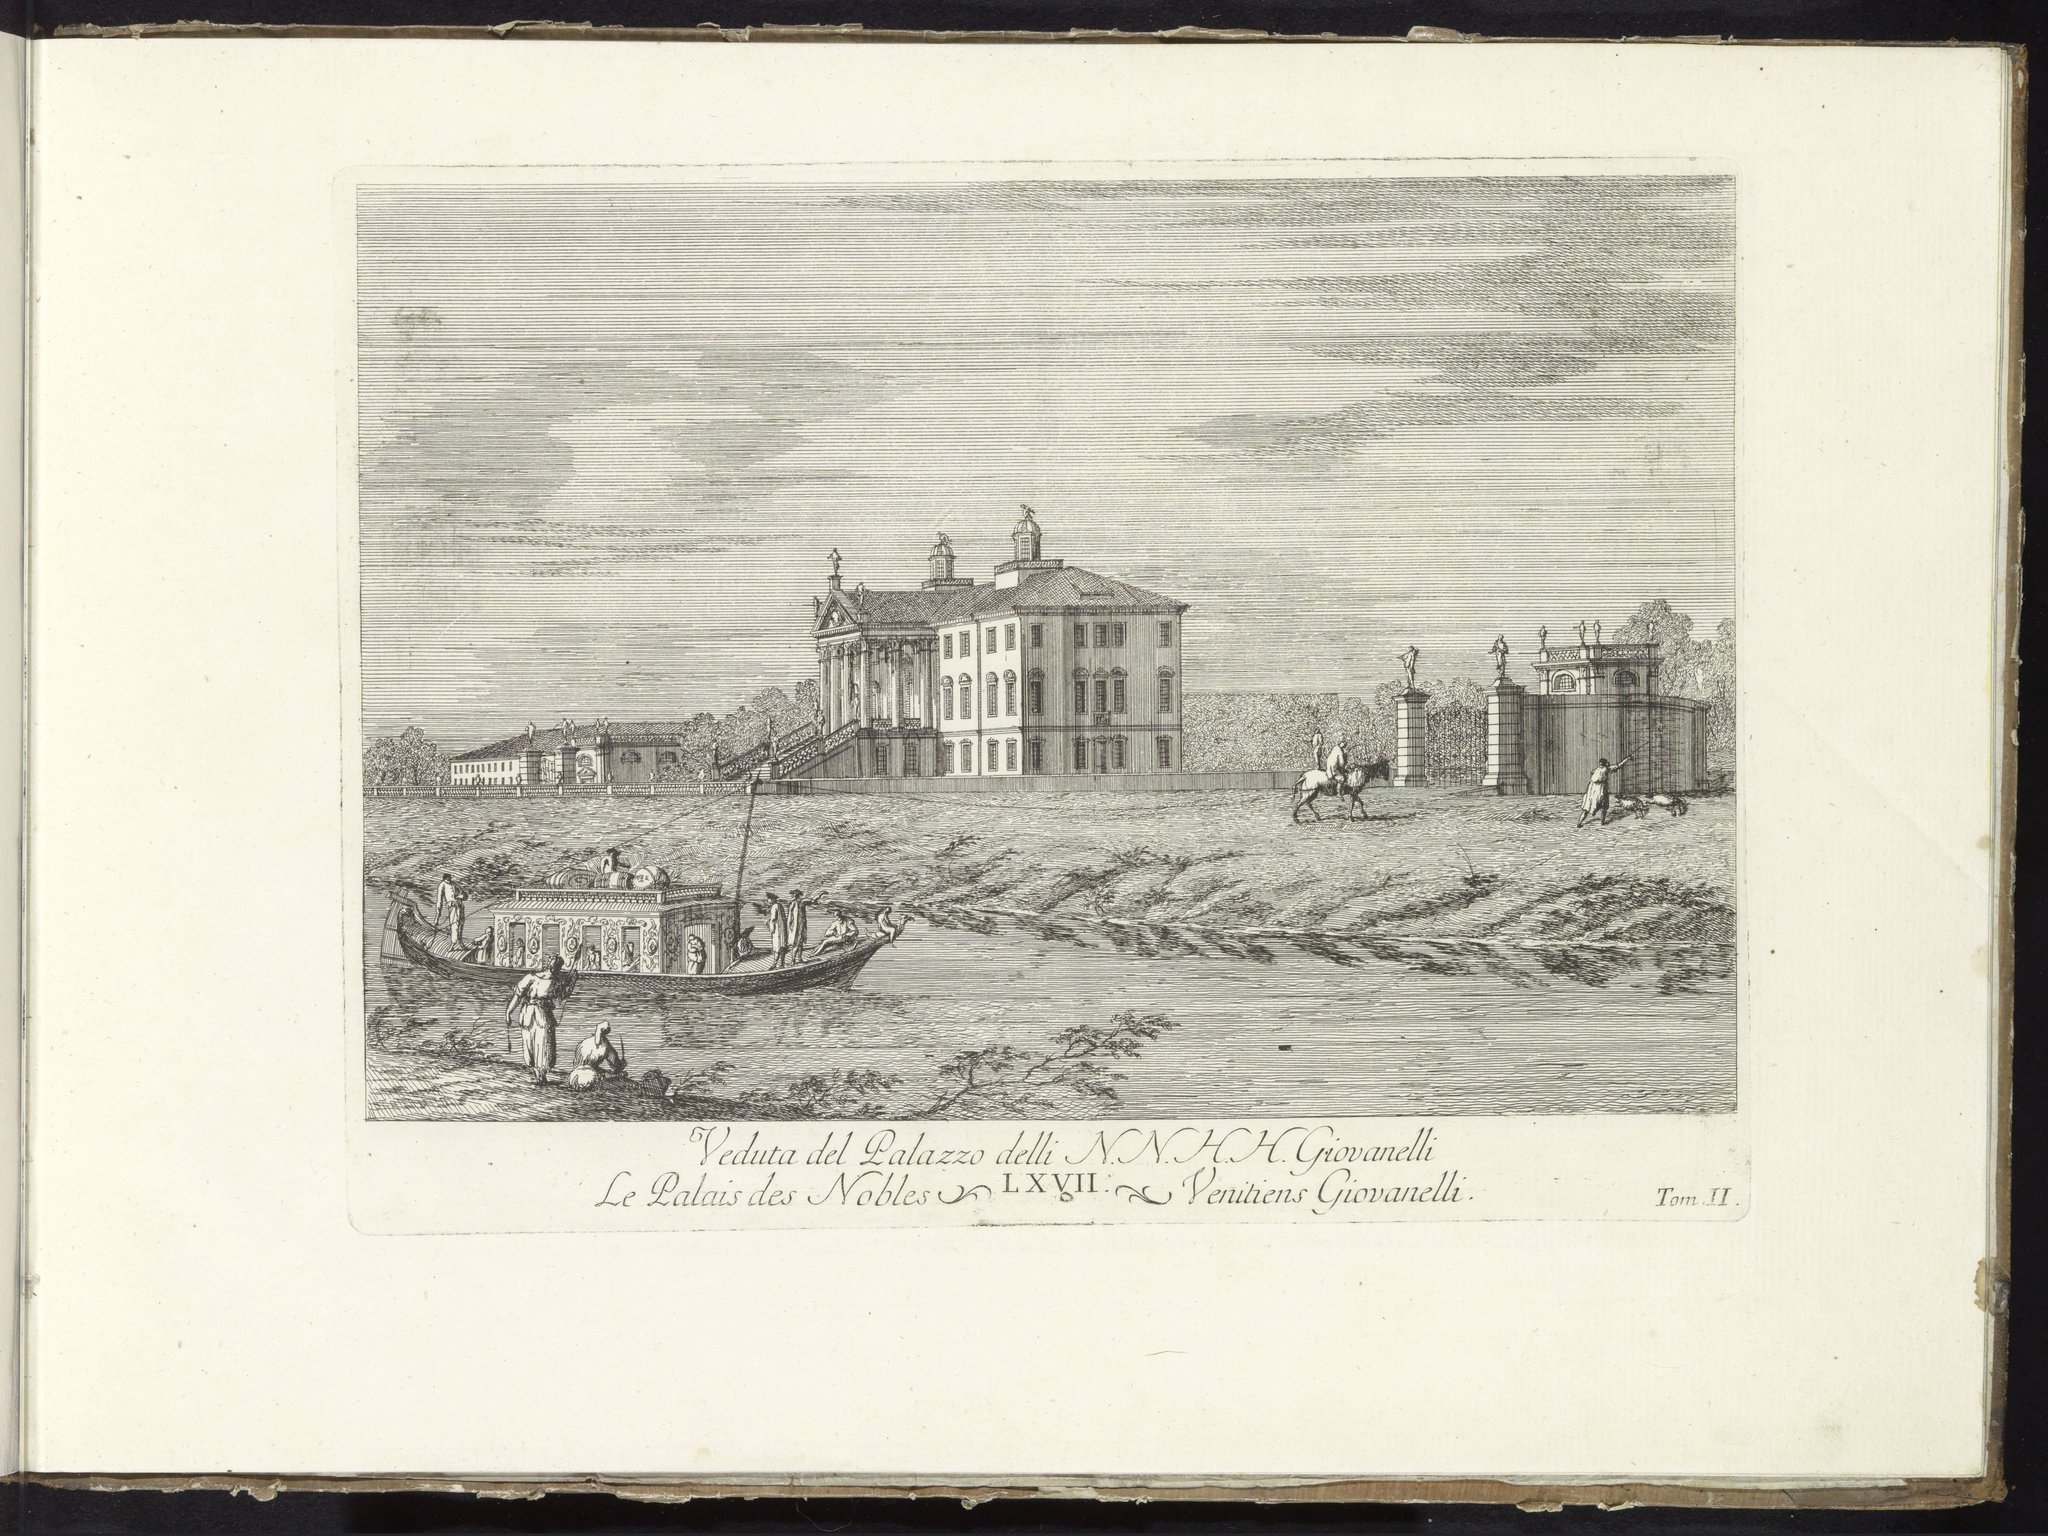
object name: print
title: Veduta del Palazzo delli N. N. H. H. Giovanell (...)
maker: giovanni francesco costa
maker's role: draughtsman, painter, print maker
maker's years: -1773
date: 1750-1760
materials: paper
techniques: etching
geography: italy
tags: river, tow-boat, towing-barge, hôtel, i.e. small palace in city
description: Gezicht op Palazzo delli N. N. H. H. Giovanelli aan de rivier de Brenta. Genummerd midden onder: LXVII en rechtsonder: Tom: II. Deze prent maakt deel uit van een album.